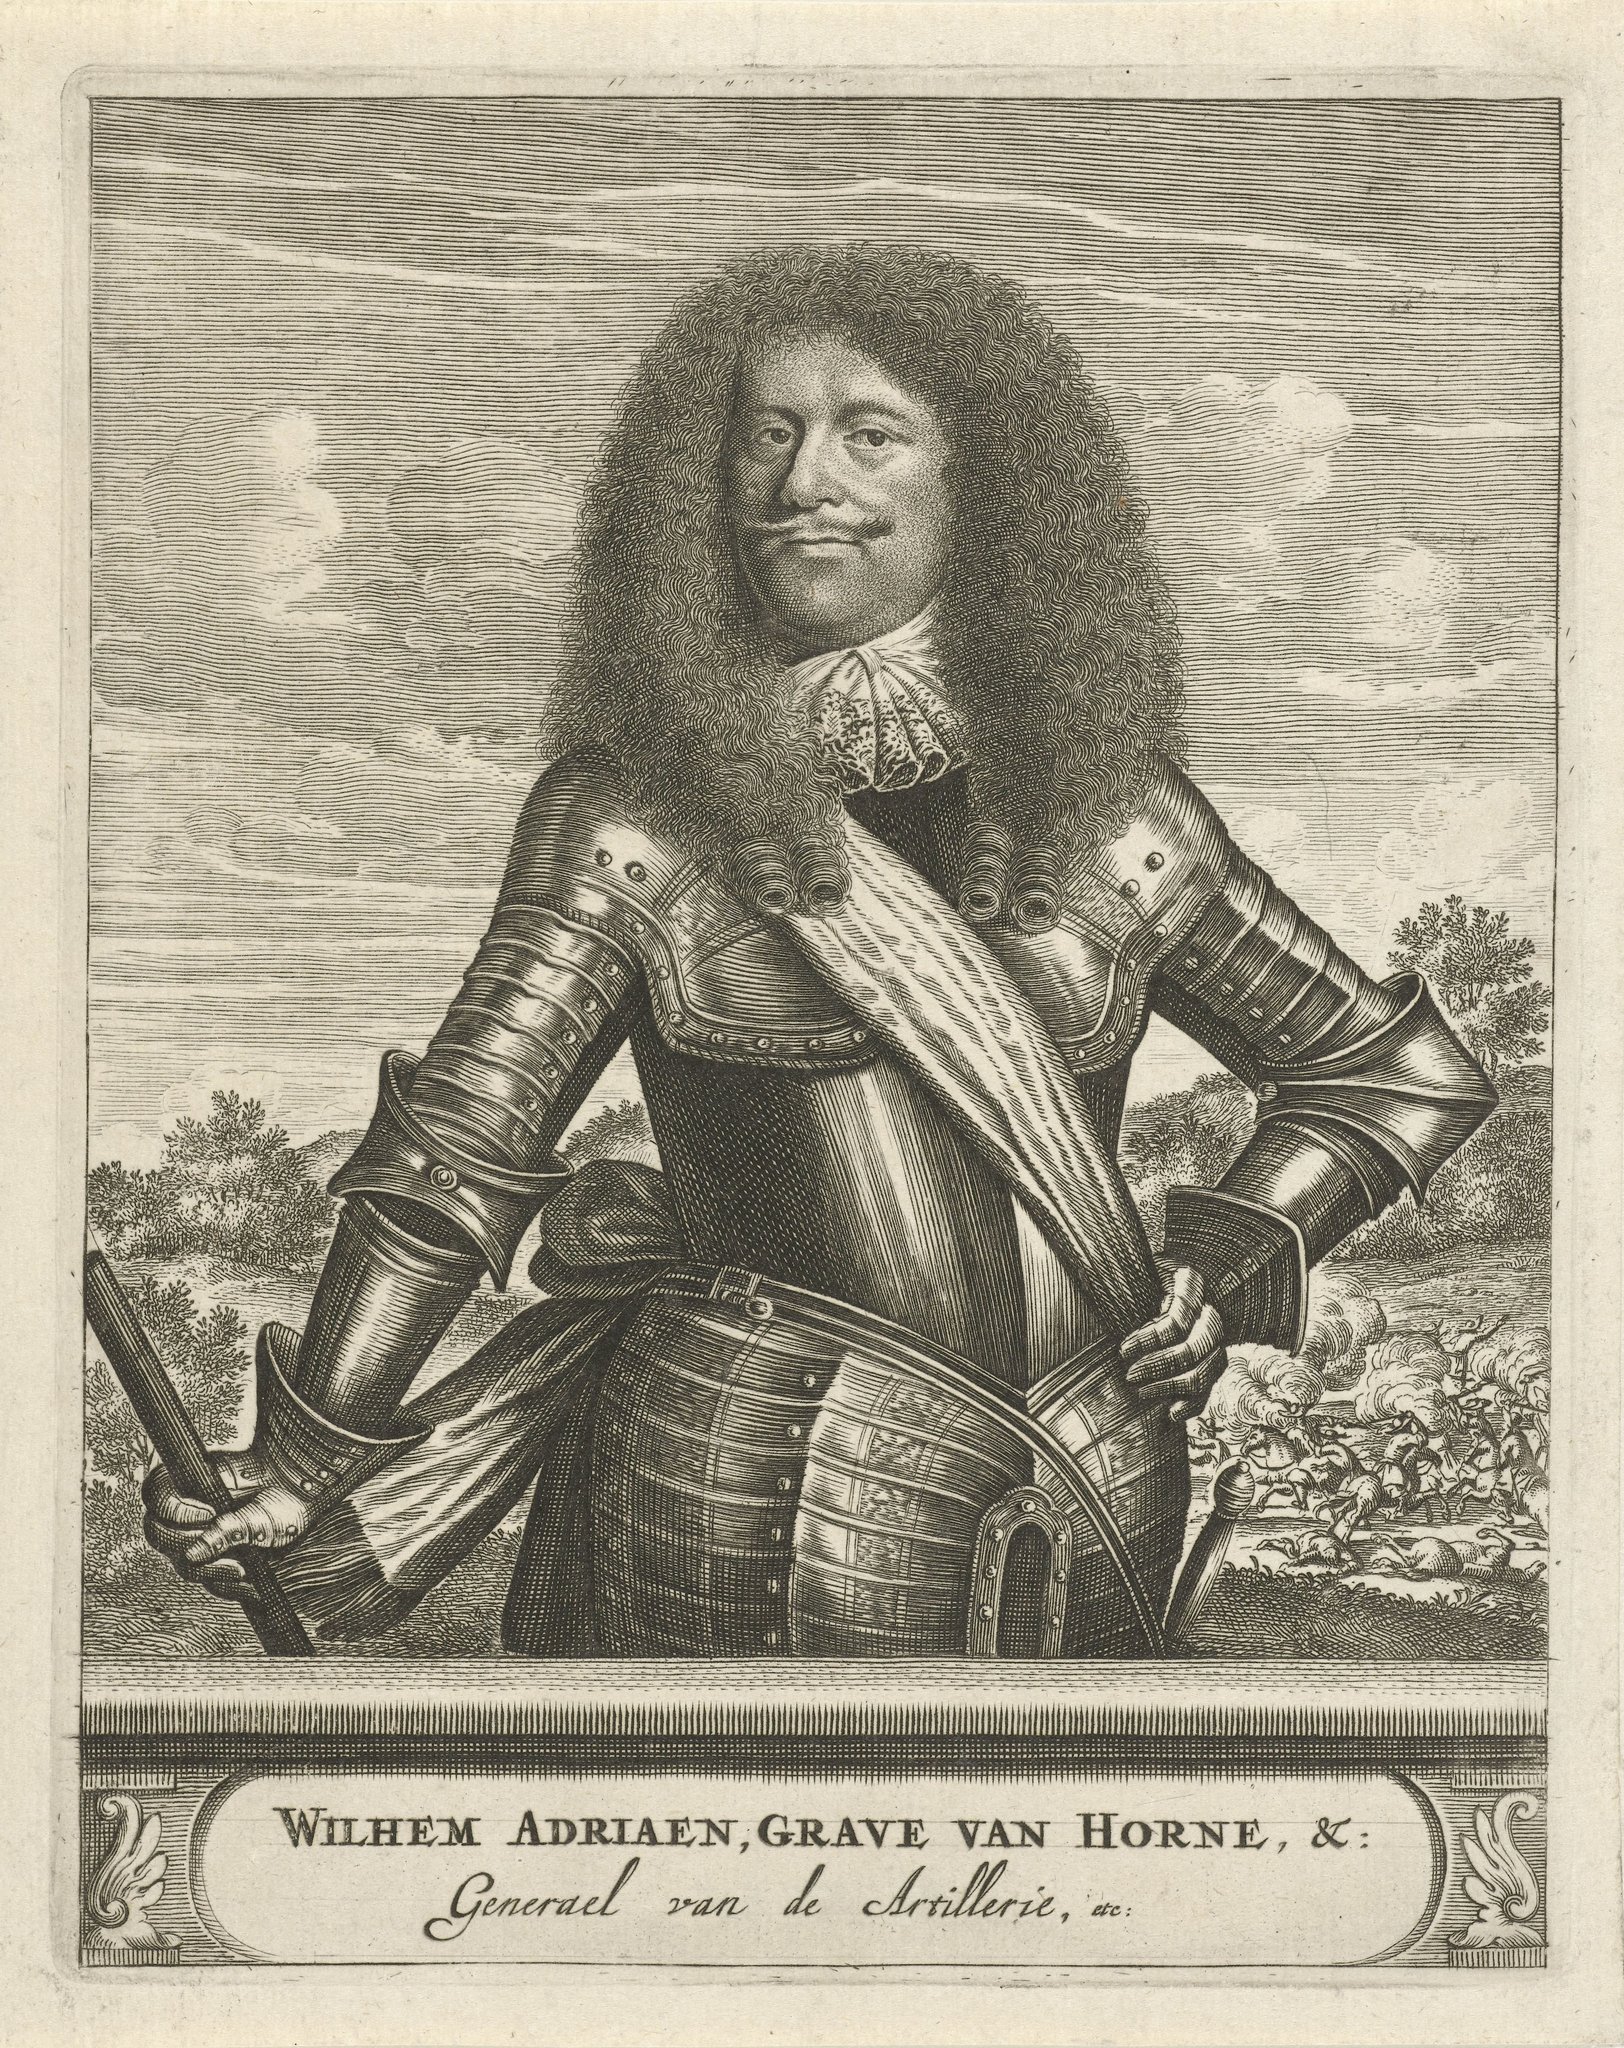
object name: print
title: Portret van Willem Adriaan, graaf van Hornes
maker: christiaan hagen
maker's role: draughtsman, print maker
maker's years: 1635-1707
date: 1635-1695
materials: paper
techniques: engraving, etching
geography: amsterdam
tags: moustache, battle (+ cavalry, horsemen), military clothing and other equipment (uniforms, cap, armour, helmet, etc.)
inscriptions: collector's mark: Lugt 2228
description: Portret van Willem Adriaan, graaf van Hornes, gekleed in een harnas met in zijn rechterhand een commandostaf. Op de achtergrond is een ruiterslag afgebeeld. Onder zijn portret een plint, waarop zijn naam en titel in twee regels in een cartouche.